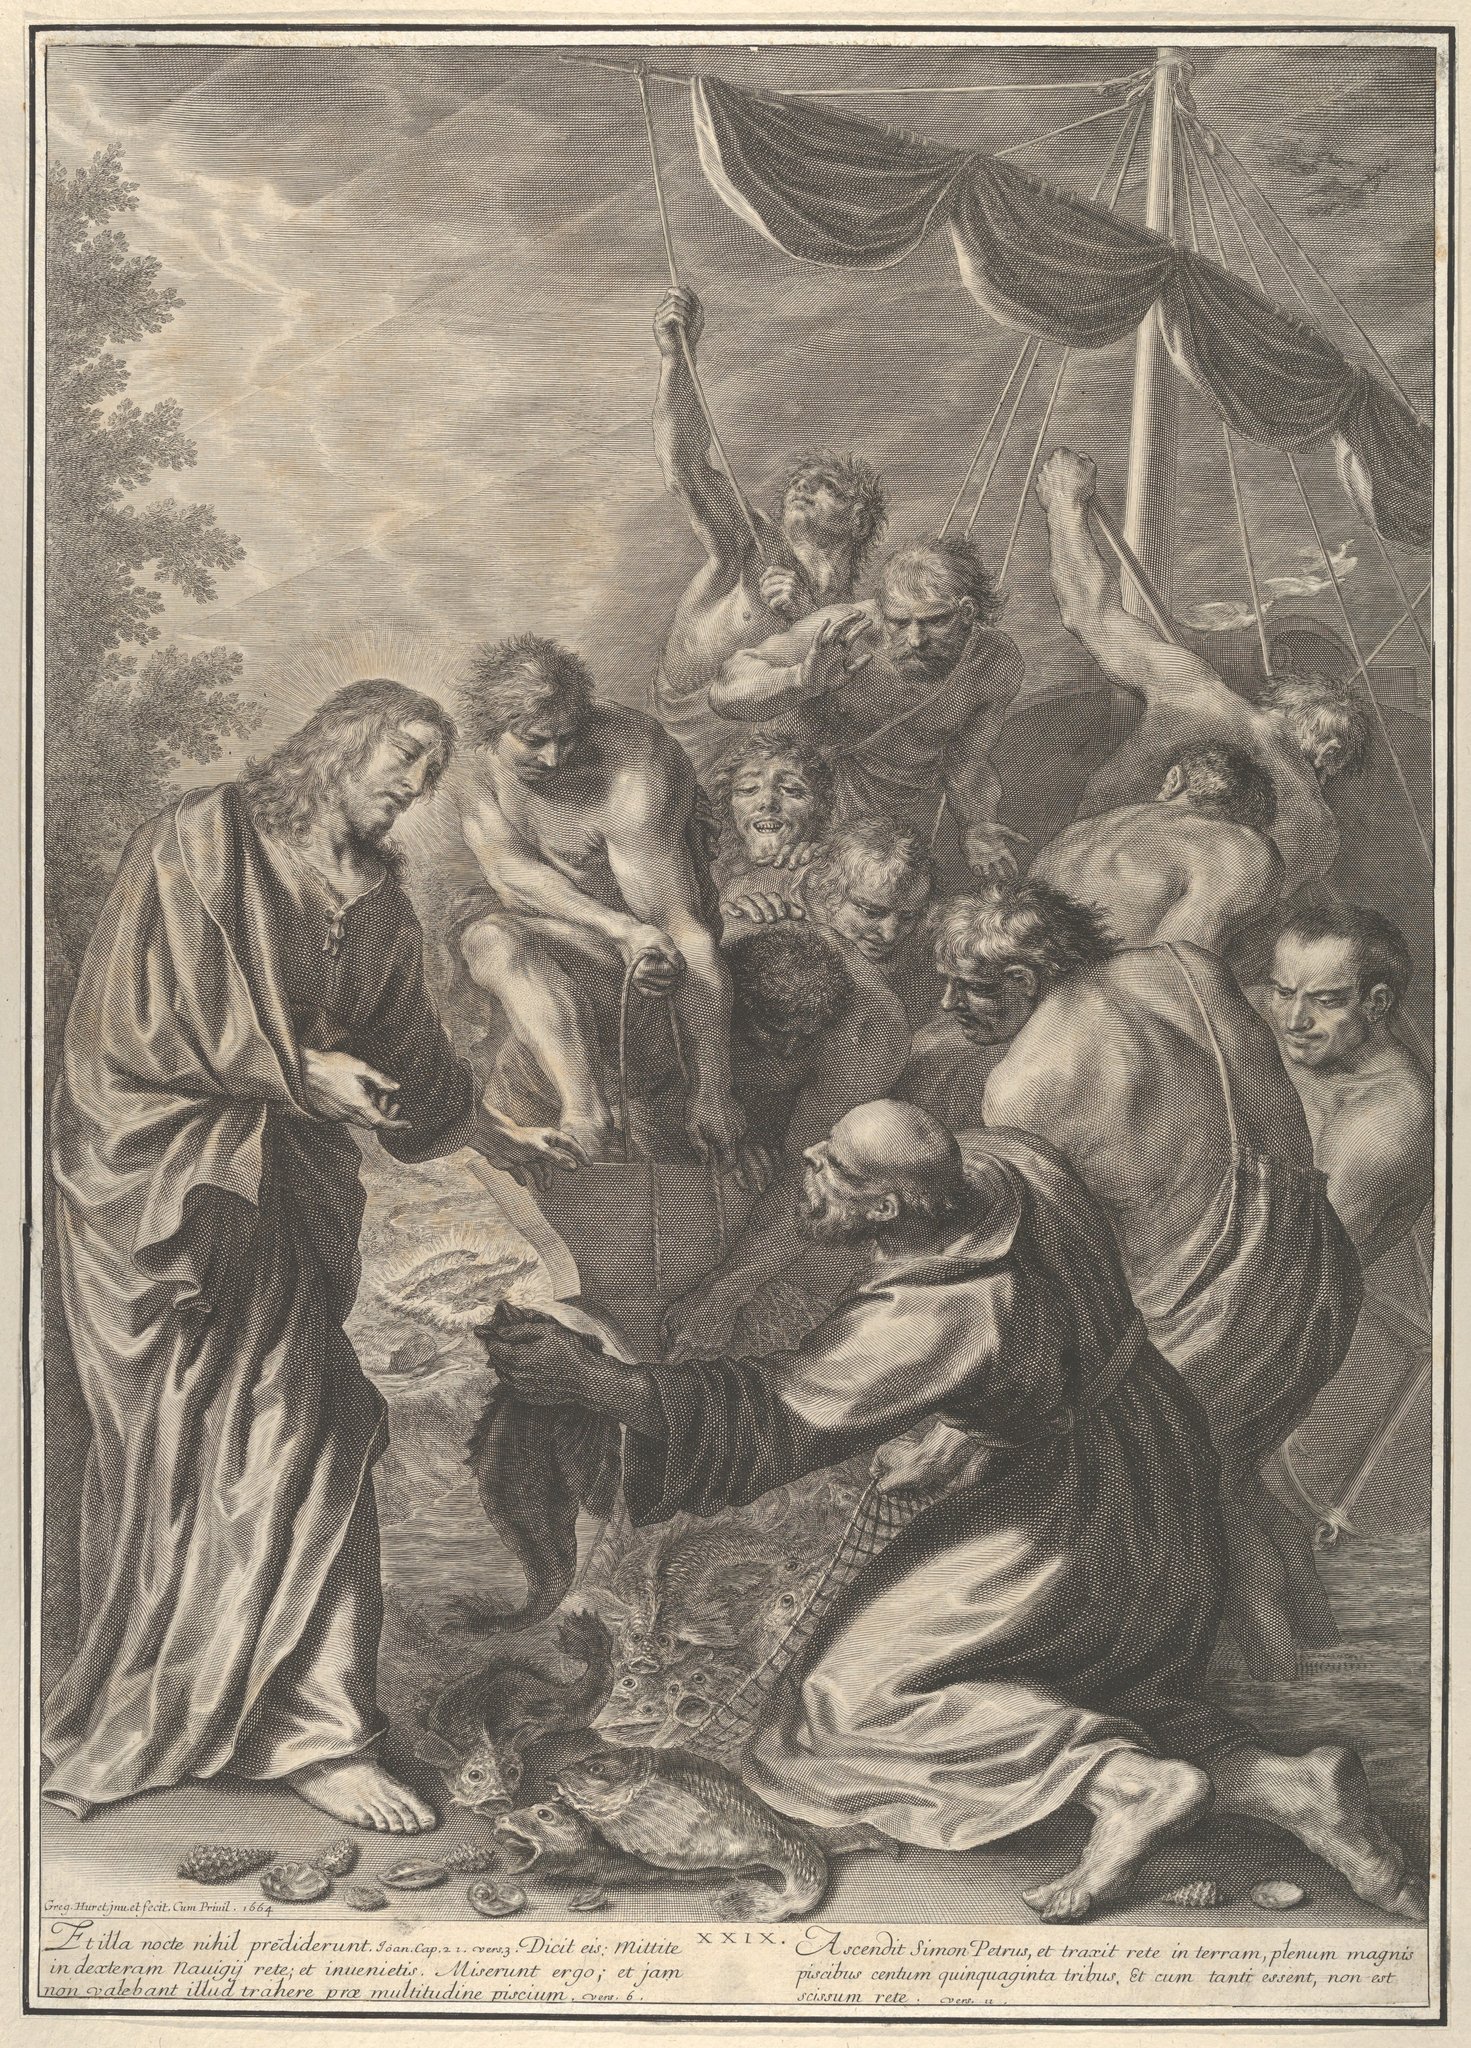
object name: print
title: Miraculous Draught of Fishes, from The Passion of Christ, plate 29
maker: grégoire huret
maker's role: artist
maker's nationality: french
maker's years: 1606-1670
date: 1664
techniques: engraving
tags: men,fish,christ